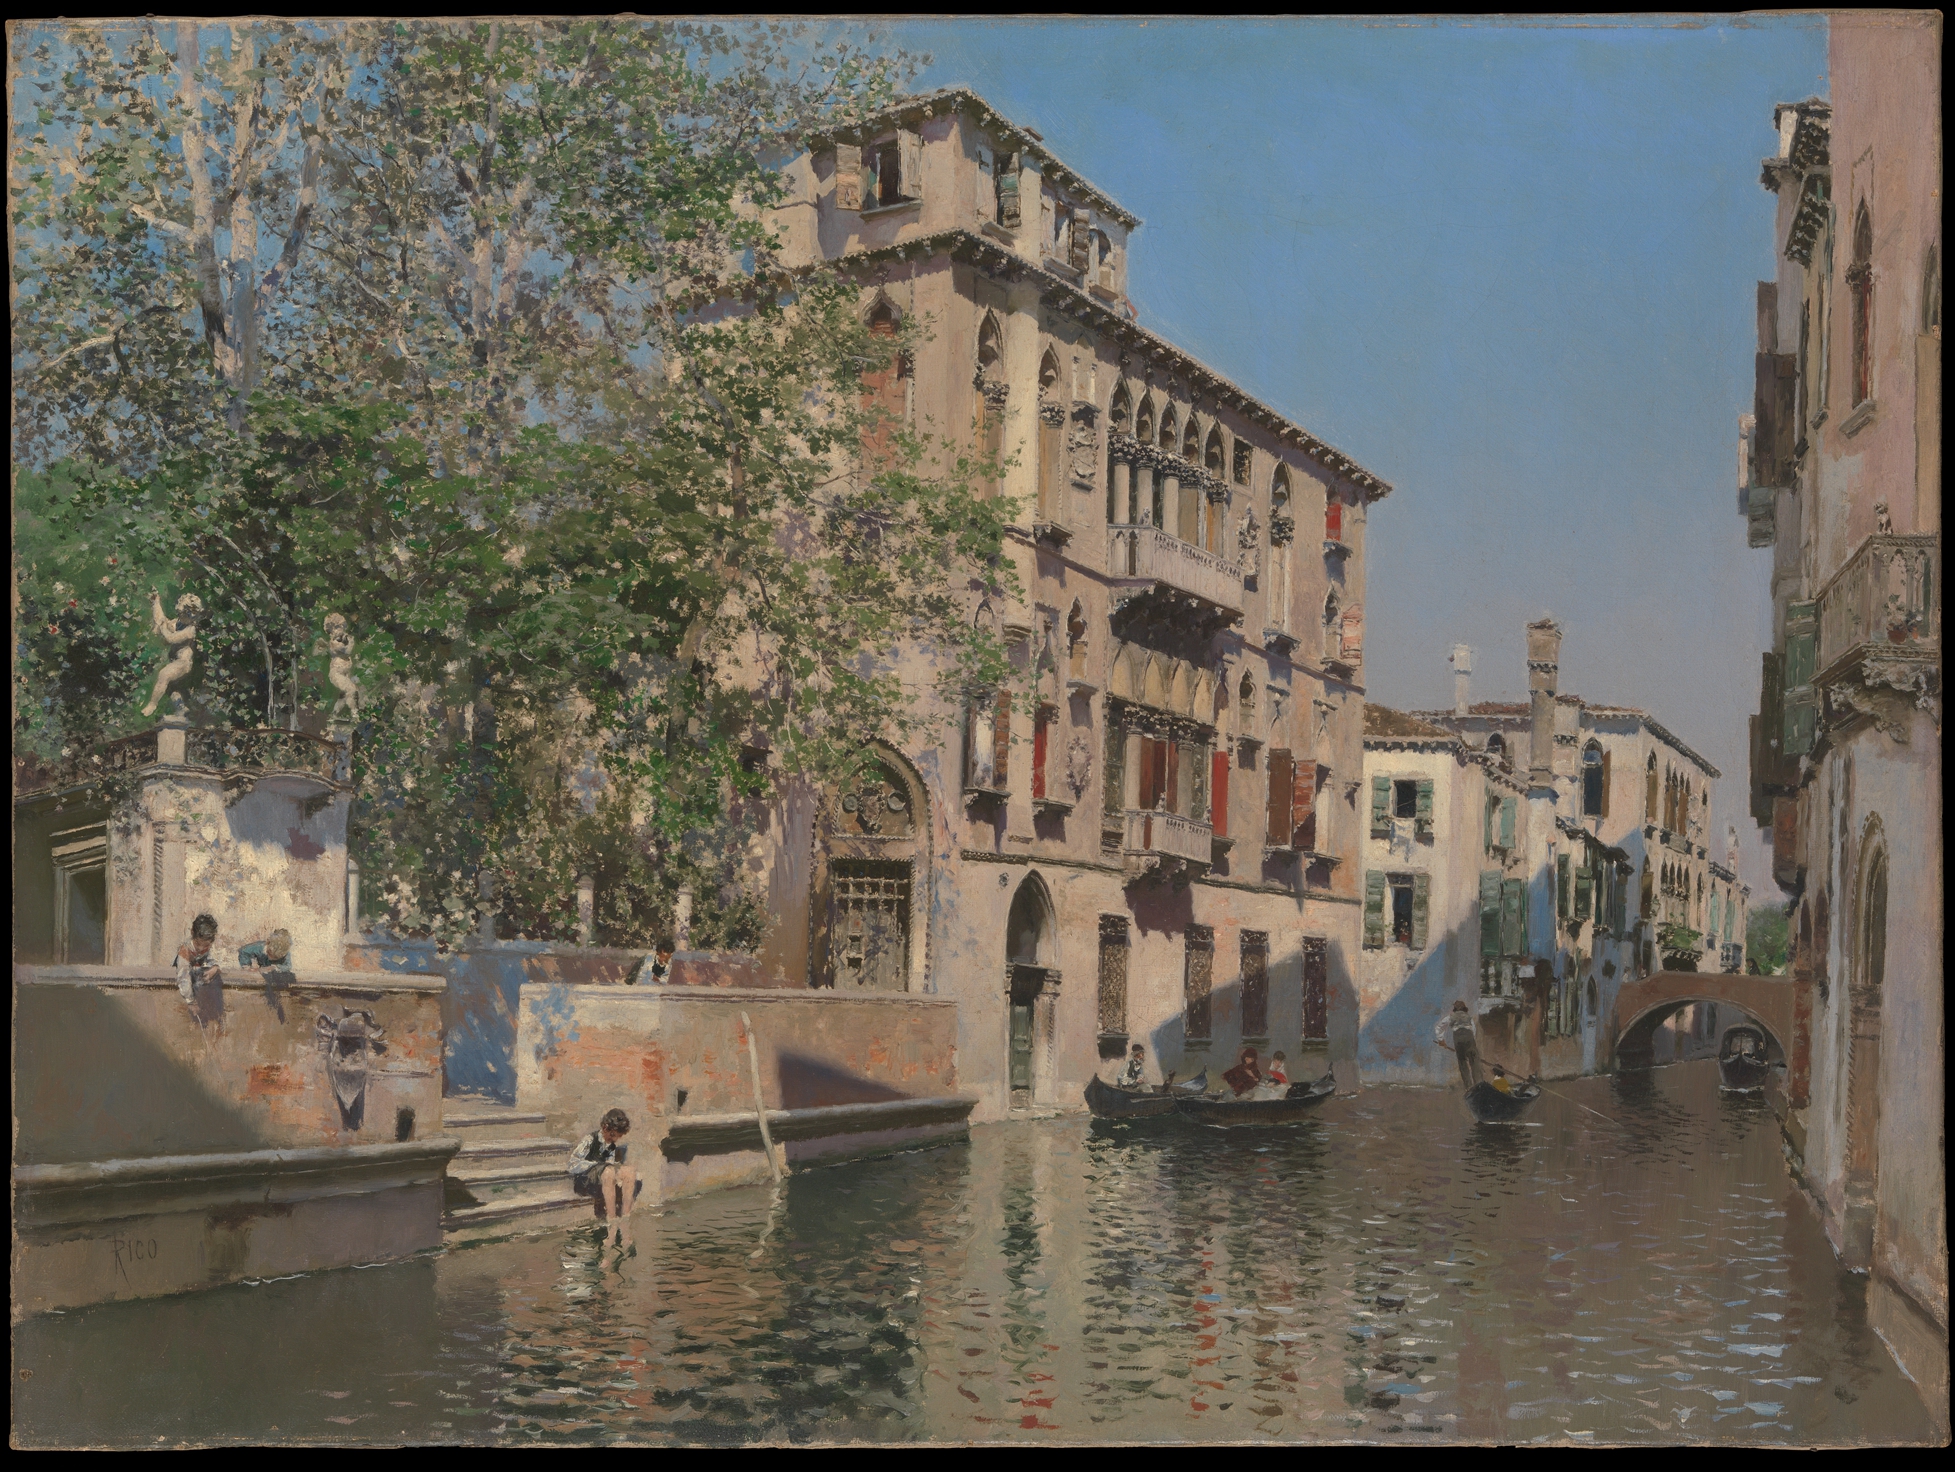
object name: painting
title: A Canal in Venice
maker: martín rico y ortega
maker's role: artist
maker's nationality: spanish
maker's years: 1833-1908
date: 1879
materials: canvas, oil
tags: buildings,cities,canals,boats,venice